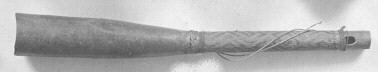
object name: caracasha trumpet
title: Caracasha (trumpet)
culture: native american or brazilian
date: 1801-1900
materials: bamboo, rubber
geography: brazil